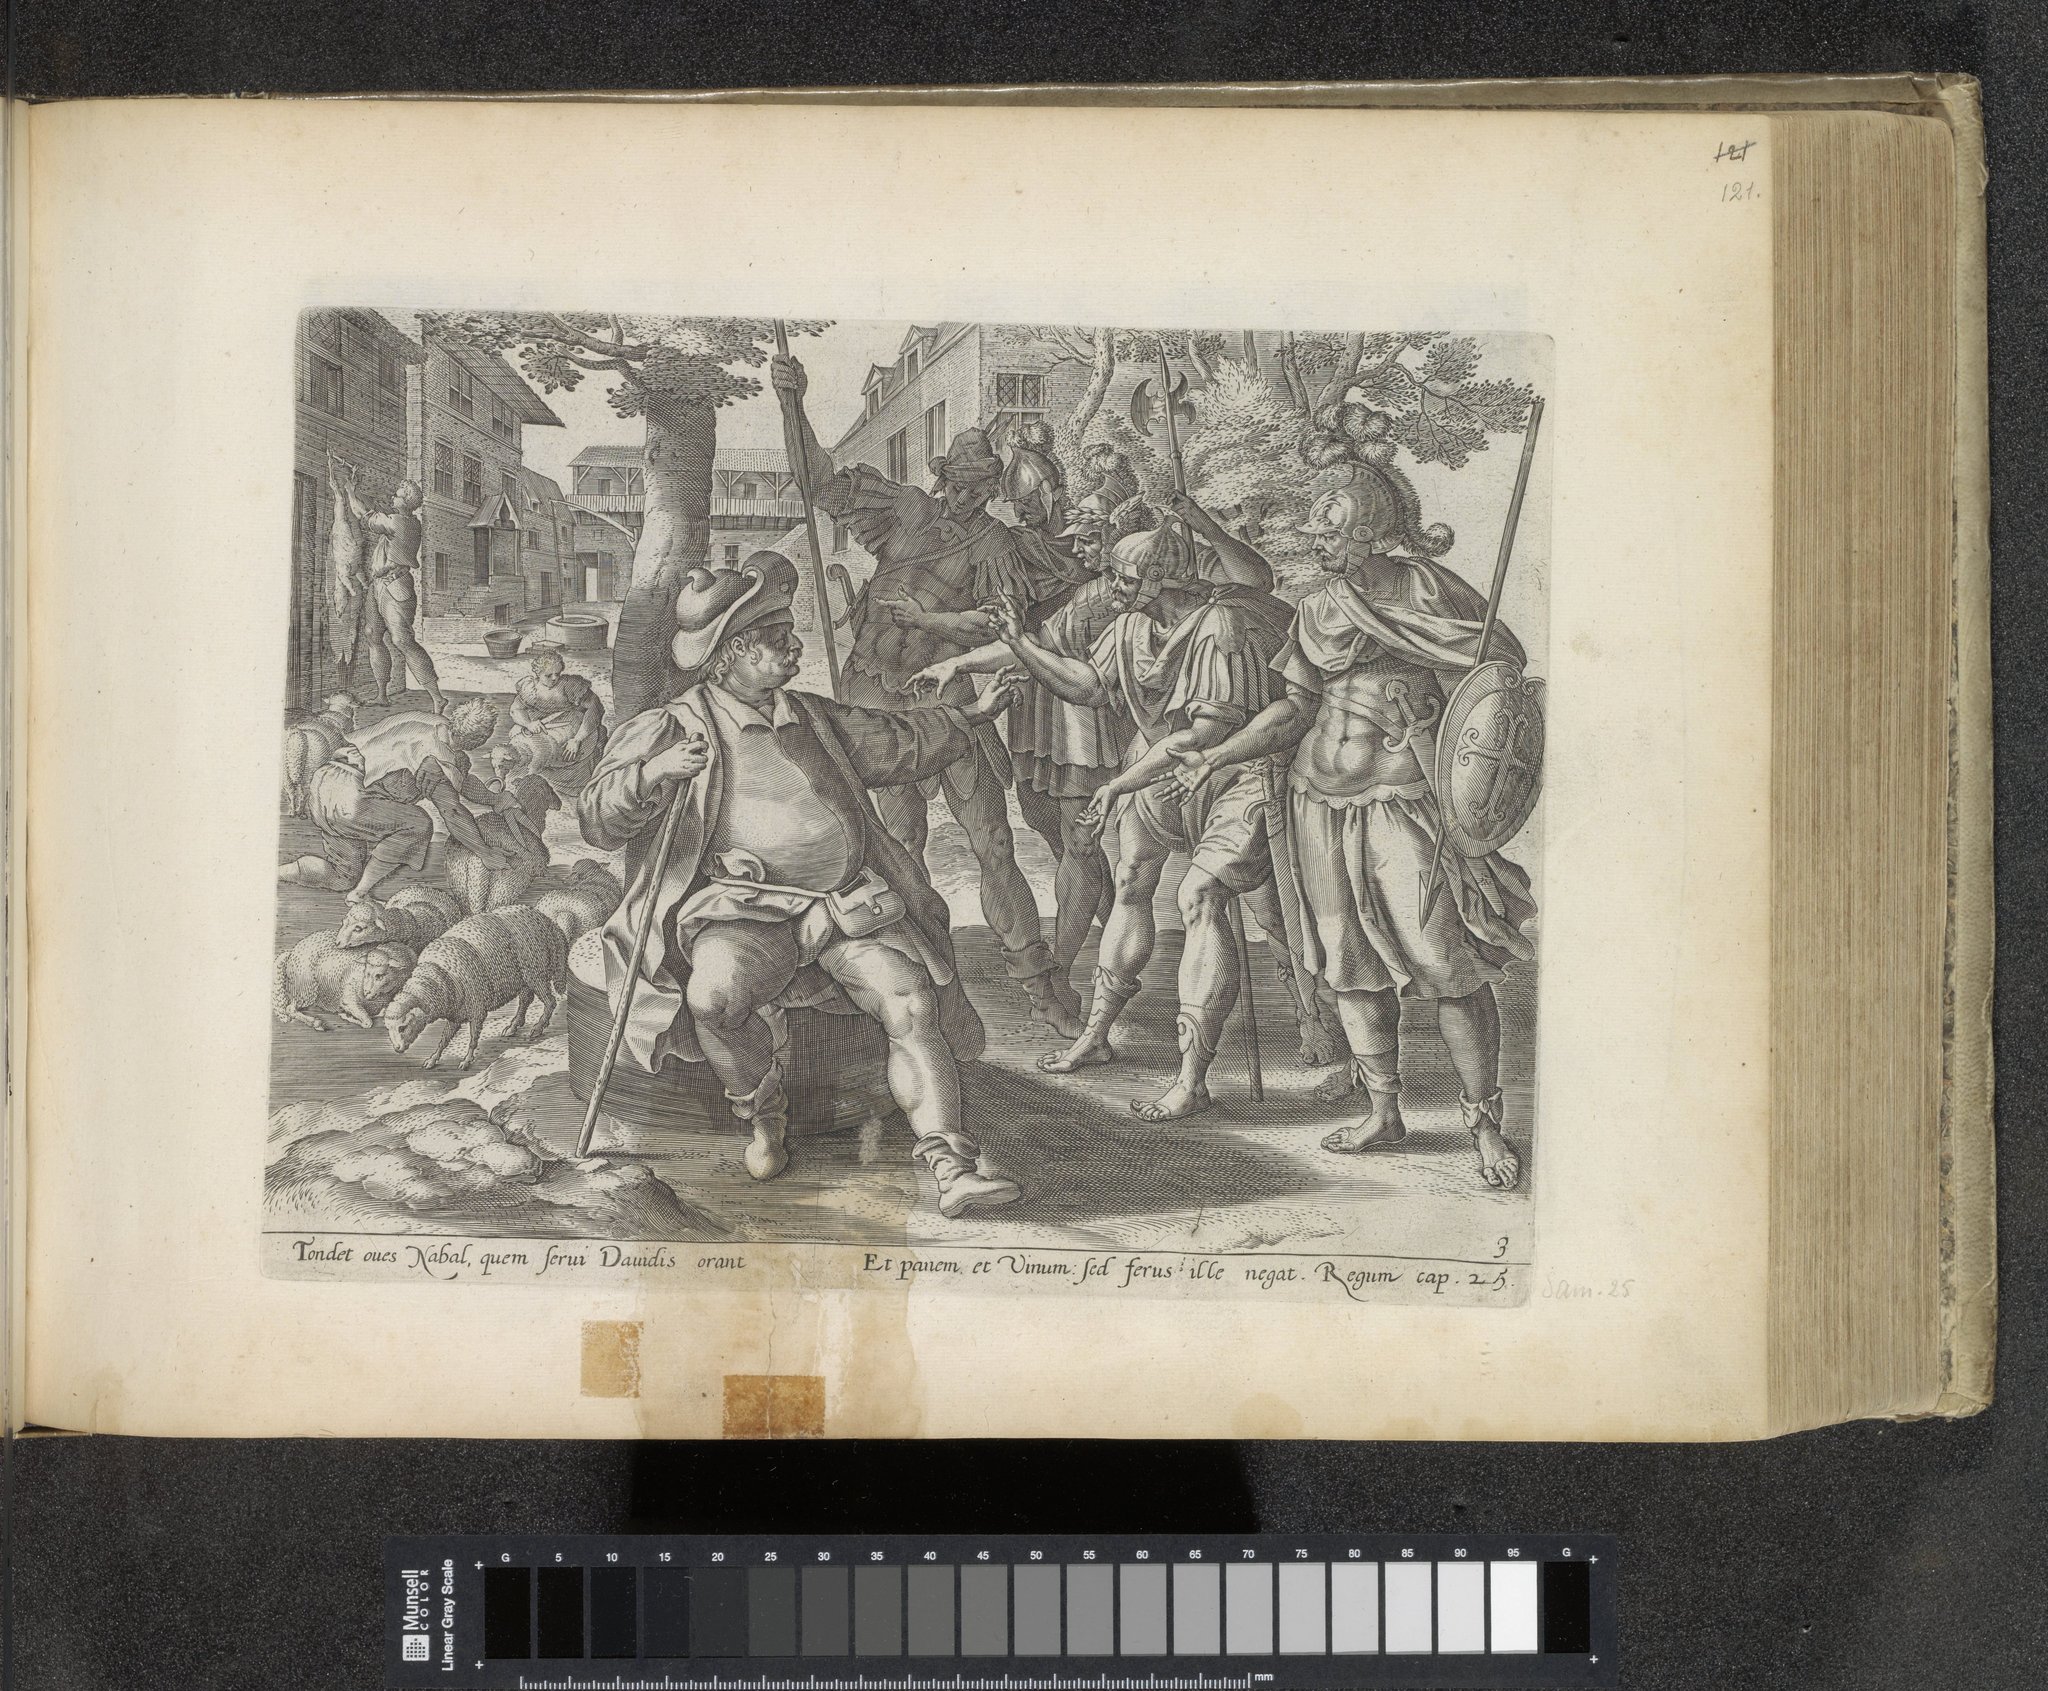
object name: print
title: Theatrum Biblicum Hoc Est Historiae Sacrae Veteris et Novi Testamenti Tabulis Aeneis Expressae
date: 1585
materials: paper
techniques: engraving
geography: amsterdam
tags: ten servants sent by david come to nabal to ask for food; nabal and his men may be shown shearing sheep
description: Davids knechten komen bij Nabal, die op de achtergrond zijn schapen laat scheren, en vragen hem om voedsel. Nabal weigert de mannen en David eten te geven. Onder de voorstelling een verwijzing in het Latijn naar de Bijbeltekst in 1 Sam. 25. Deze prent maakt deel uit van een album.